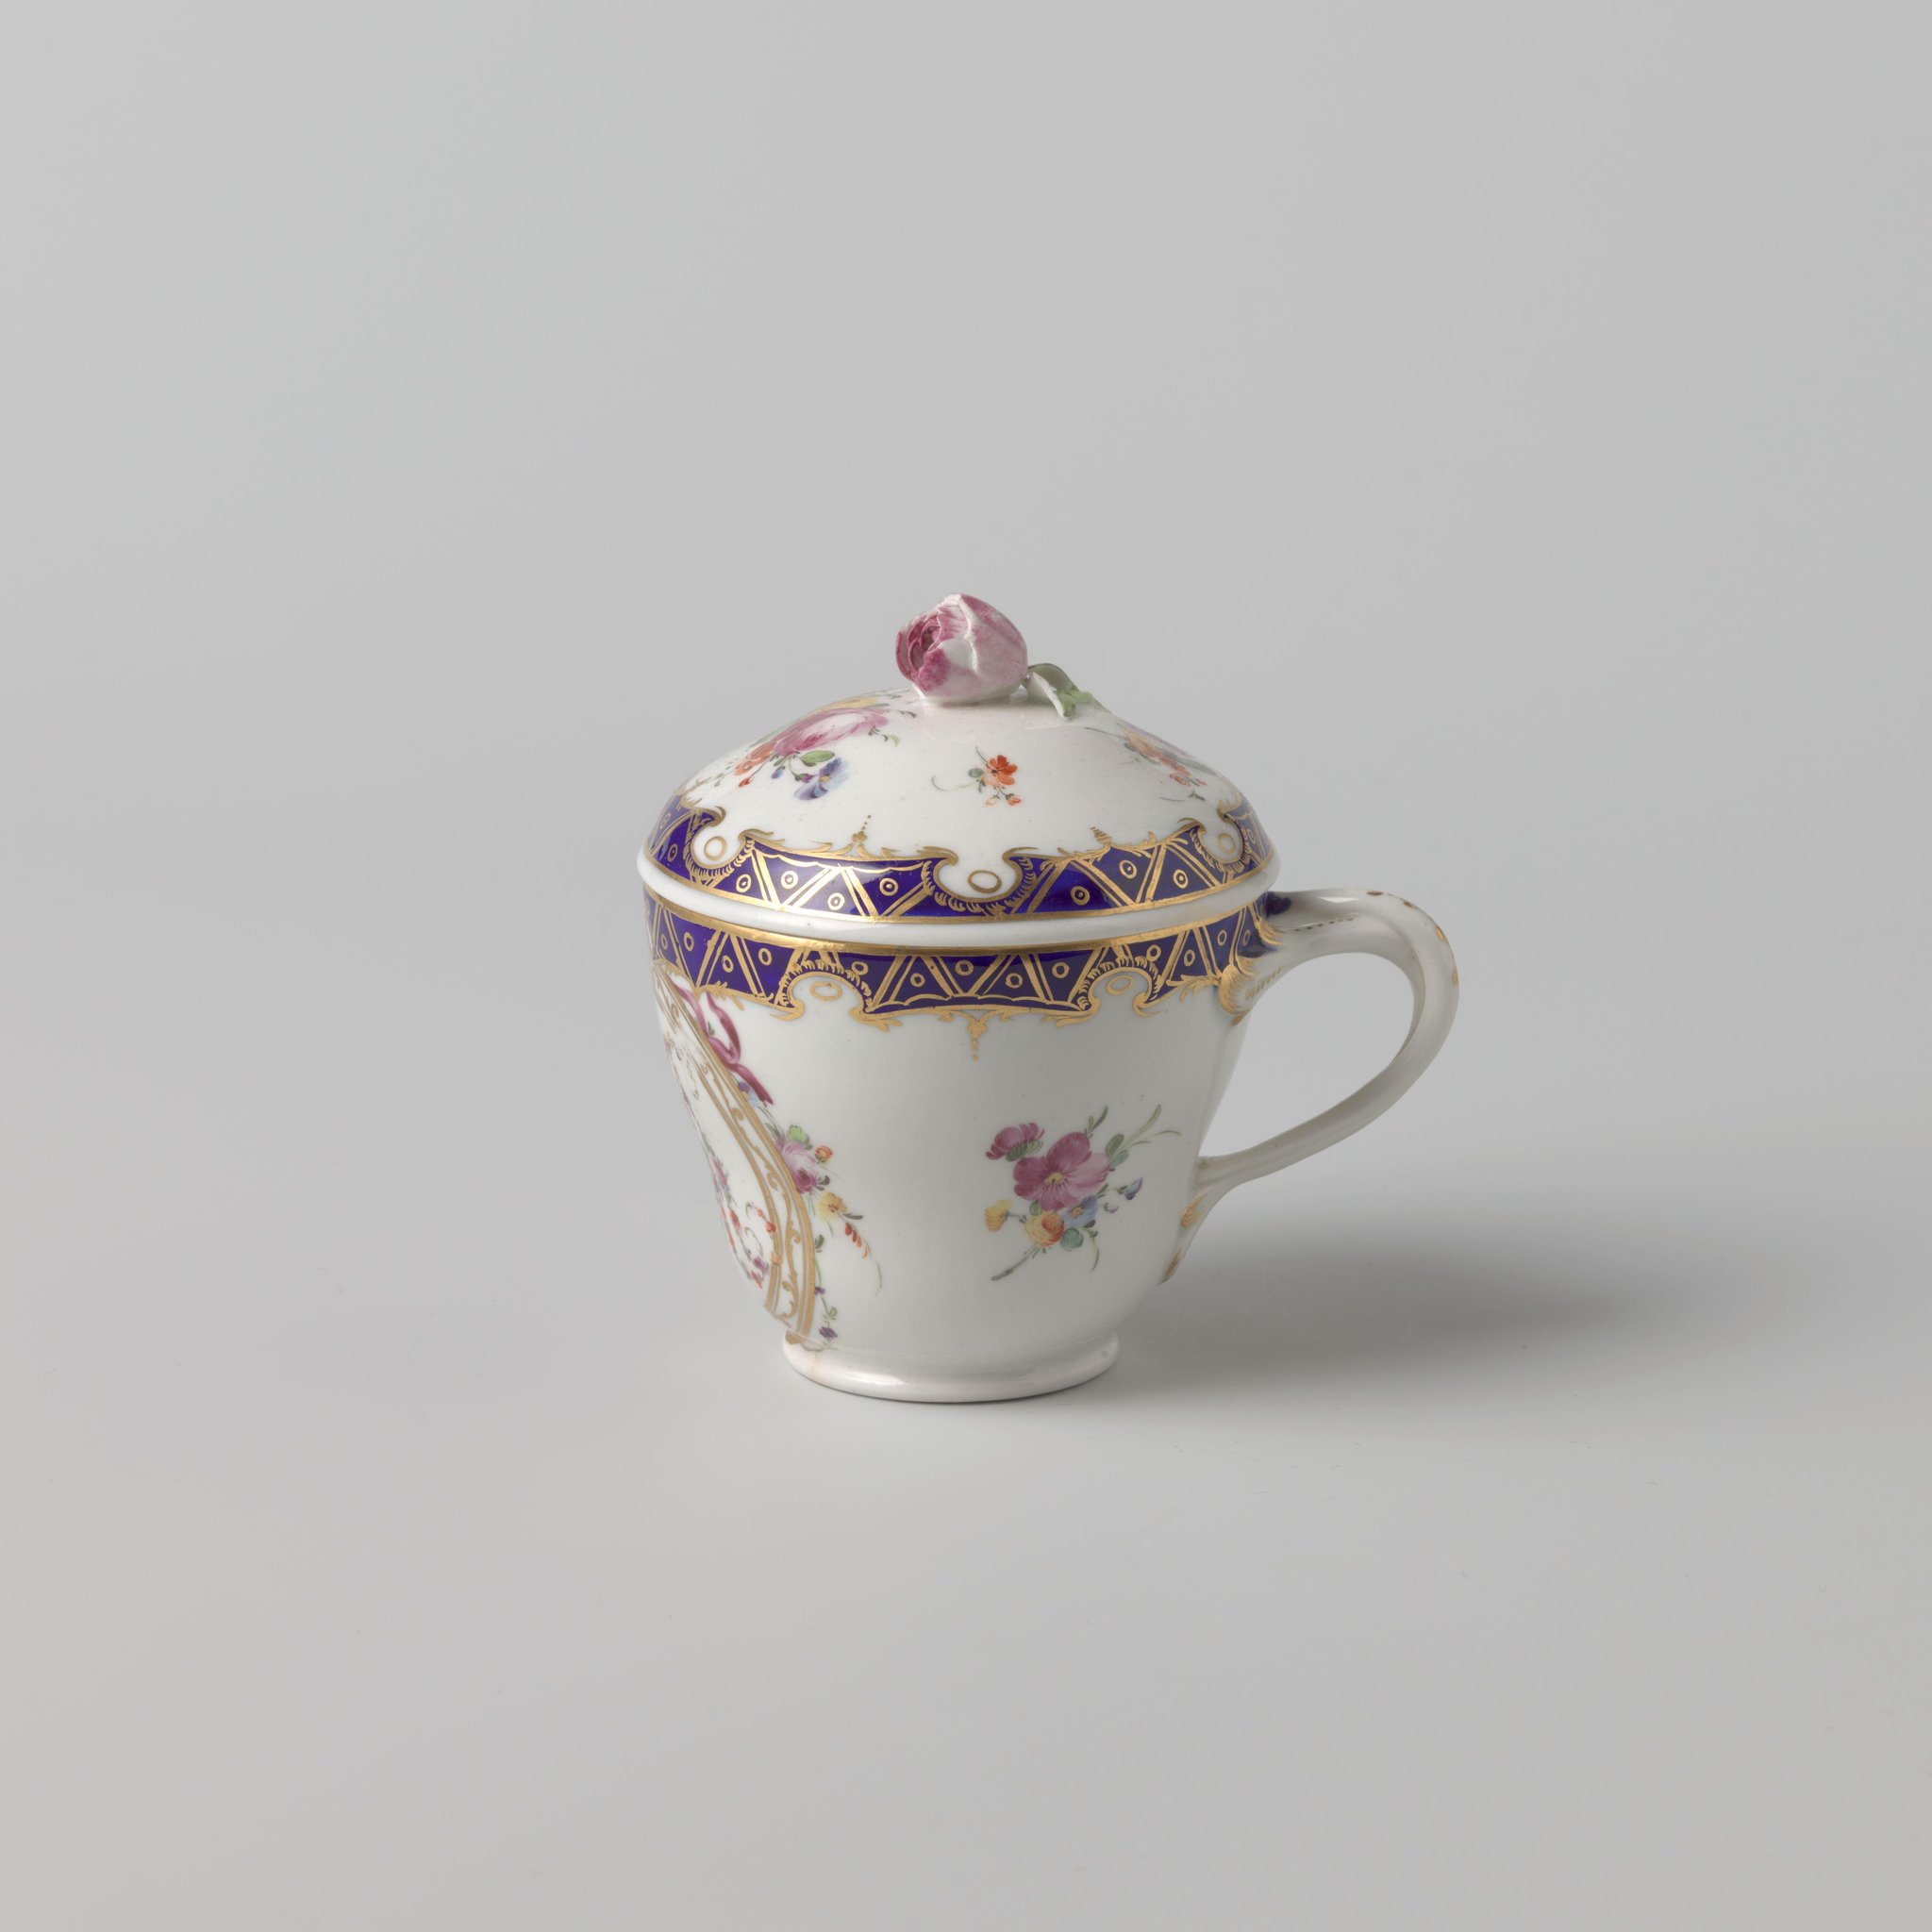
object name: lid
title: Deksel van chocoladekop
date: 1777-1790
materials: porcelain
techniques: painted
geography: the hague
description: Deksel van chocoladekop. De randen zijn beschilderd met een blauwe band met een zigzag-motief afgesloten door rocailles in goud. De knop wordt gevormd door een bloem.